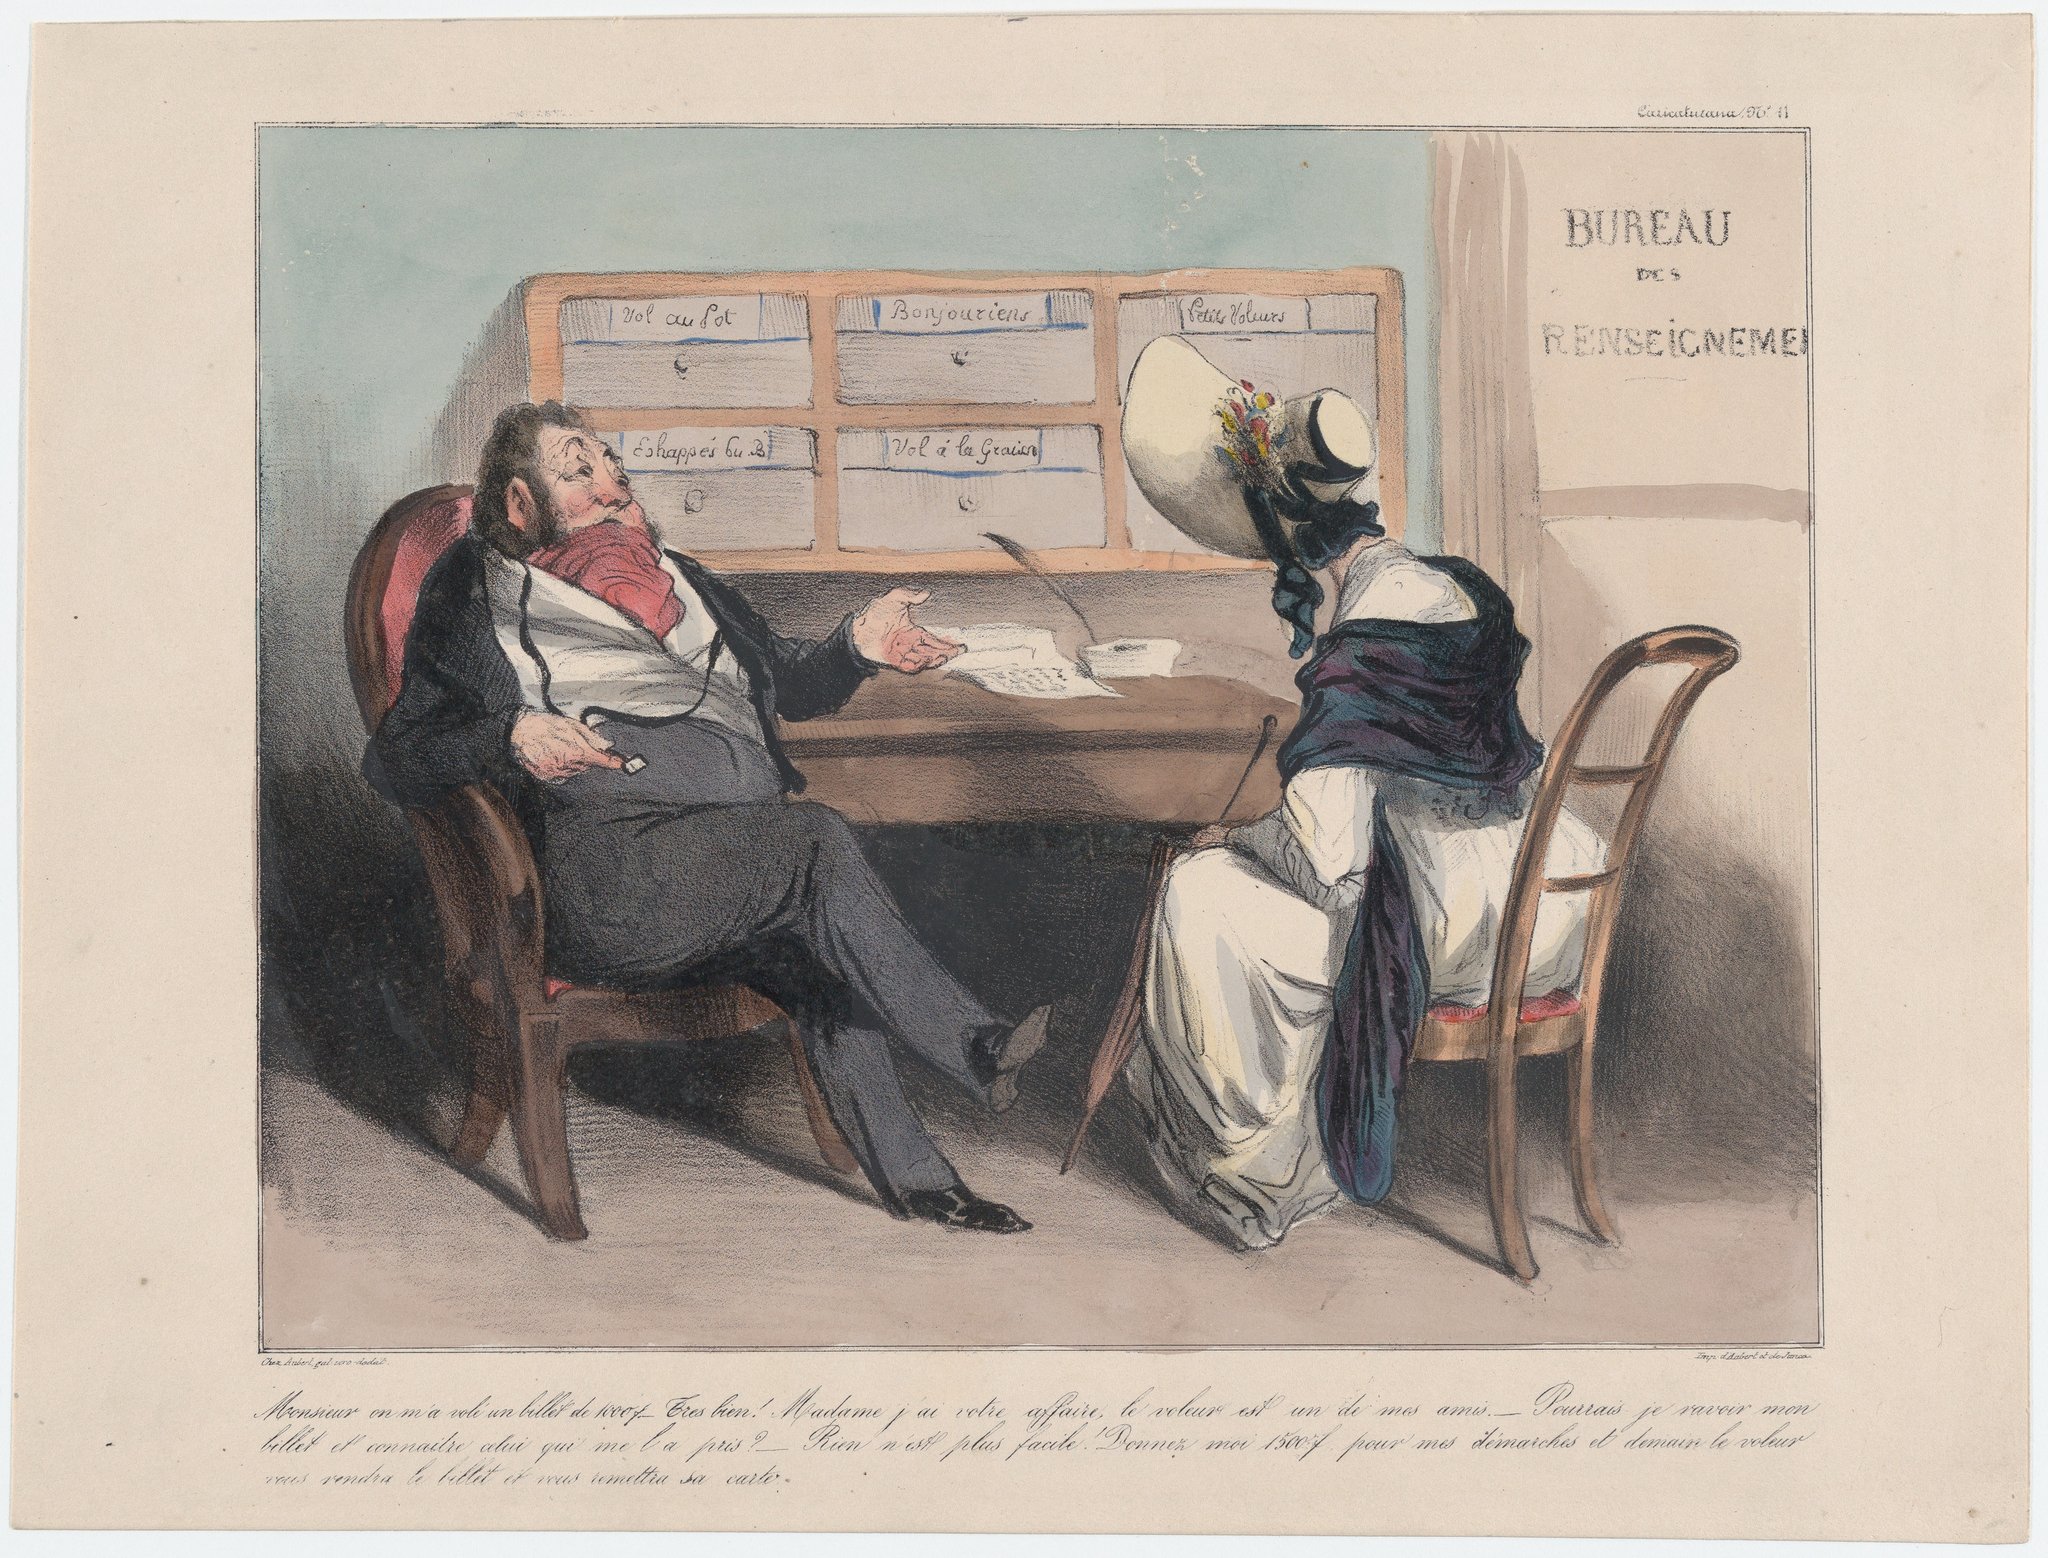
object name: print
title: Plate 11: Someone stole a thousand franc note from me, Monsieur..., from 'Caricaturana,' published in Les Robert Macaires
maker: honoré daumier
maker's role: artist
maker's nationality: french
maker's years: 1808-1879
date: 1838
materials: paper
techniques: lithograph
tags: satire,men,women